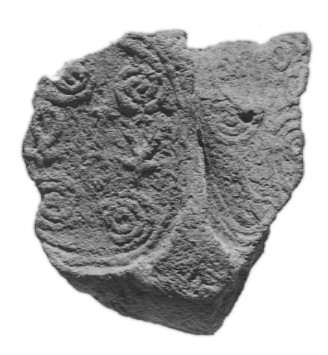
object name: sealing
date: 2030-1640 BCE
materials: clay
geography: egypt